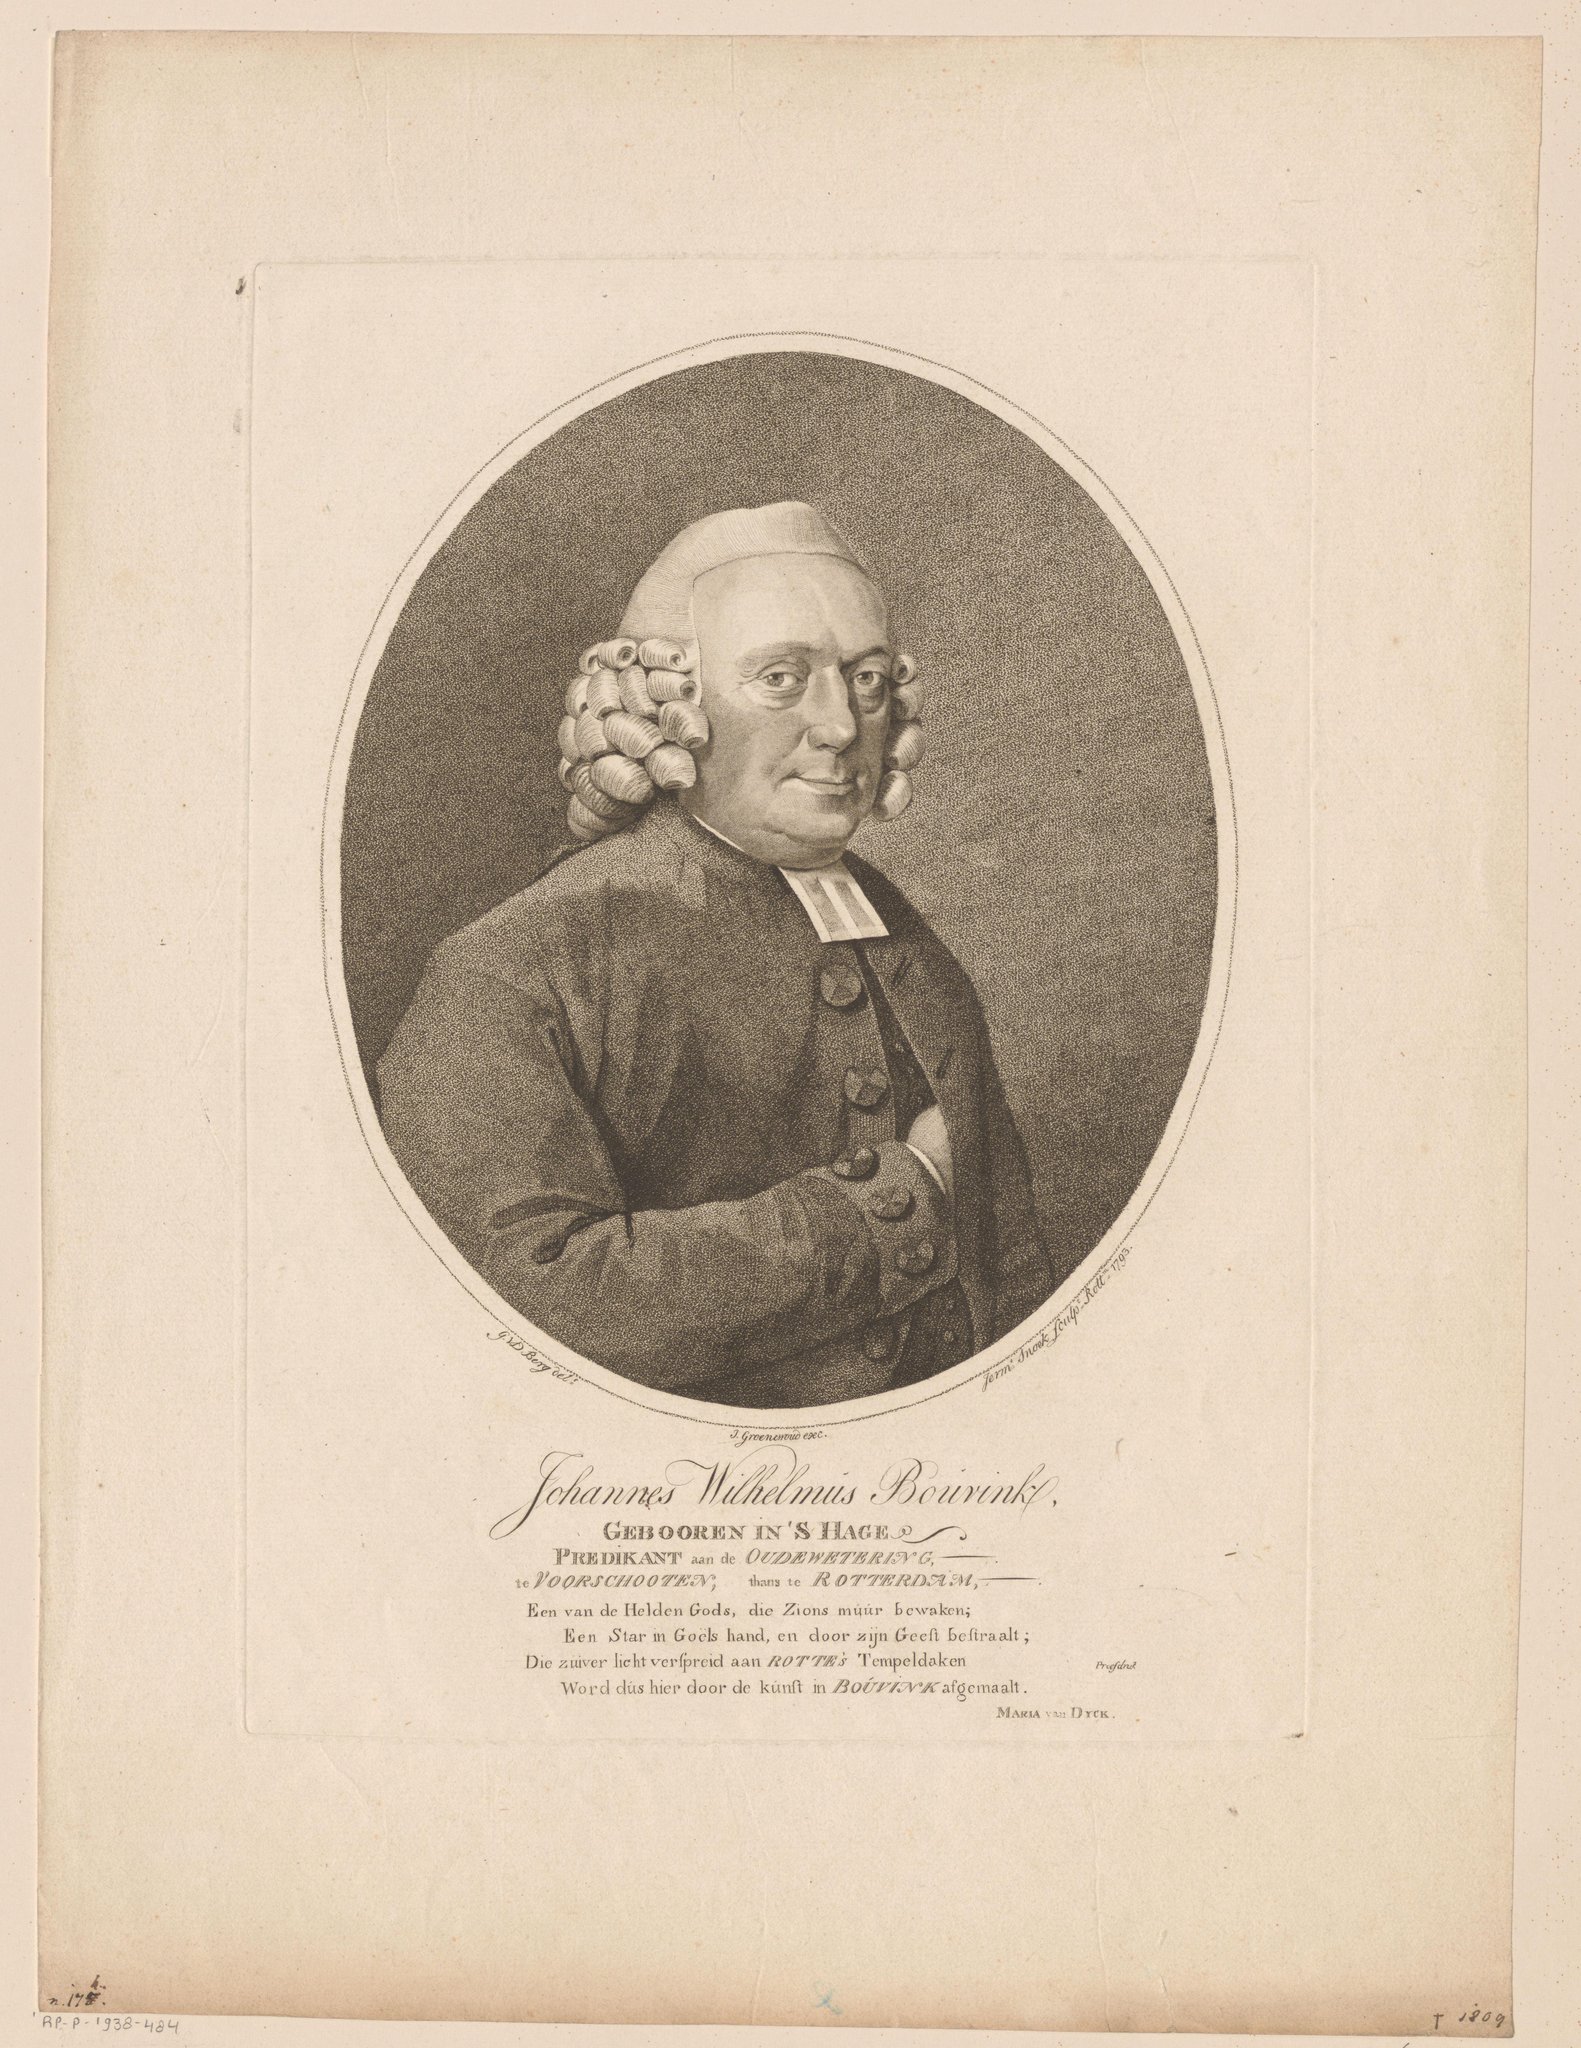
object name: print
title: Portret van Johannes Wilhelmus Bouvink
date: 1793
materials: paper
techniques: etching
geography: rotterdam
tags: the hague, historical persons, functionaries and dignitaries ~ episcopal protestant churches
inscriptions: inscription: ‘n 1744 + 1809’